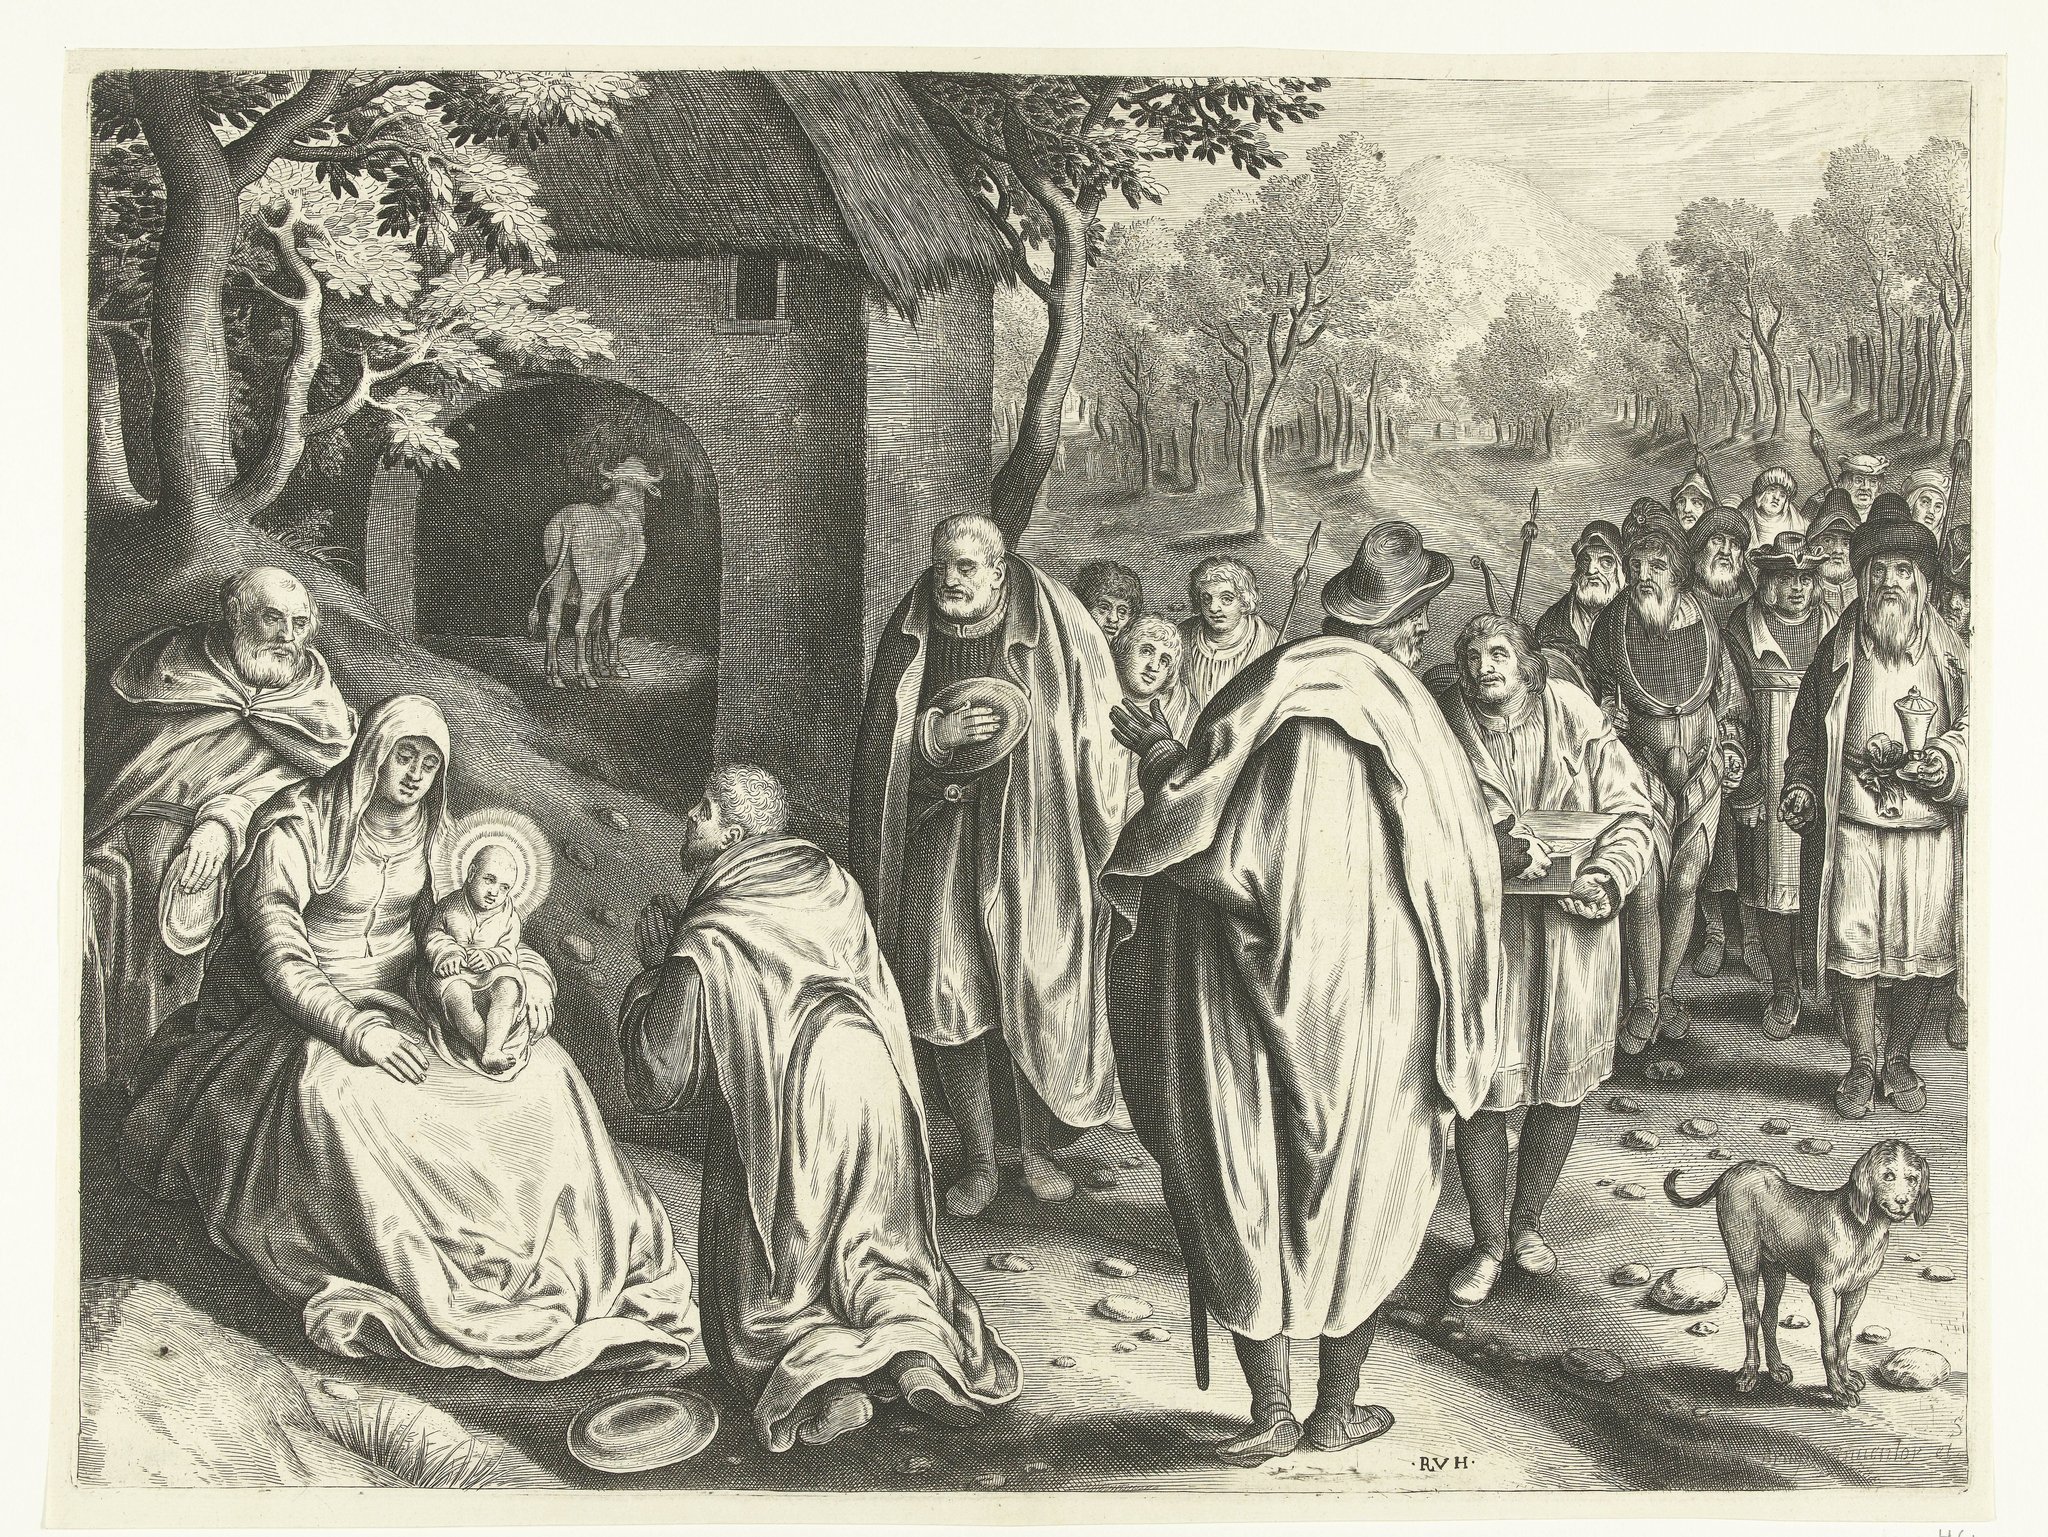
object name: print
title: Aanbidding der koningen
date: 1643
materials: paper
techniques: engraving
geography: netherlands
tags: adoration of the kings: the wise men present their gifts to the christ-child (gold, frankincense and myrrh)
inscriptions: collector's mark: Lugt 2228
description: Vergelijk exemplaar in collectie van het British Museum met adres uitgever Pieter Schenk en ander signatuur van De Bruyn, gedateerd 1643 (inv.nr. 1861,0810.439).